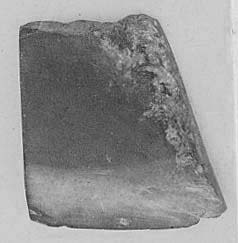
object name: knife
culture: german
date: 1902